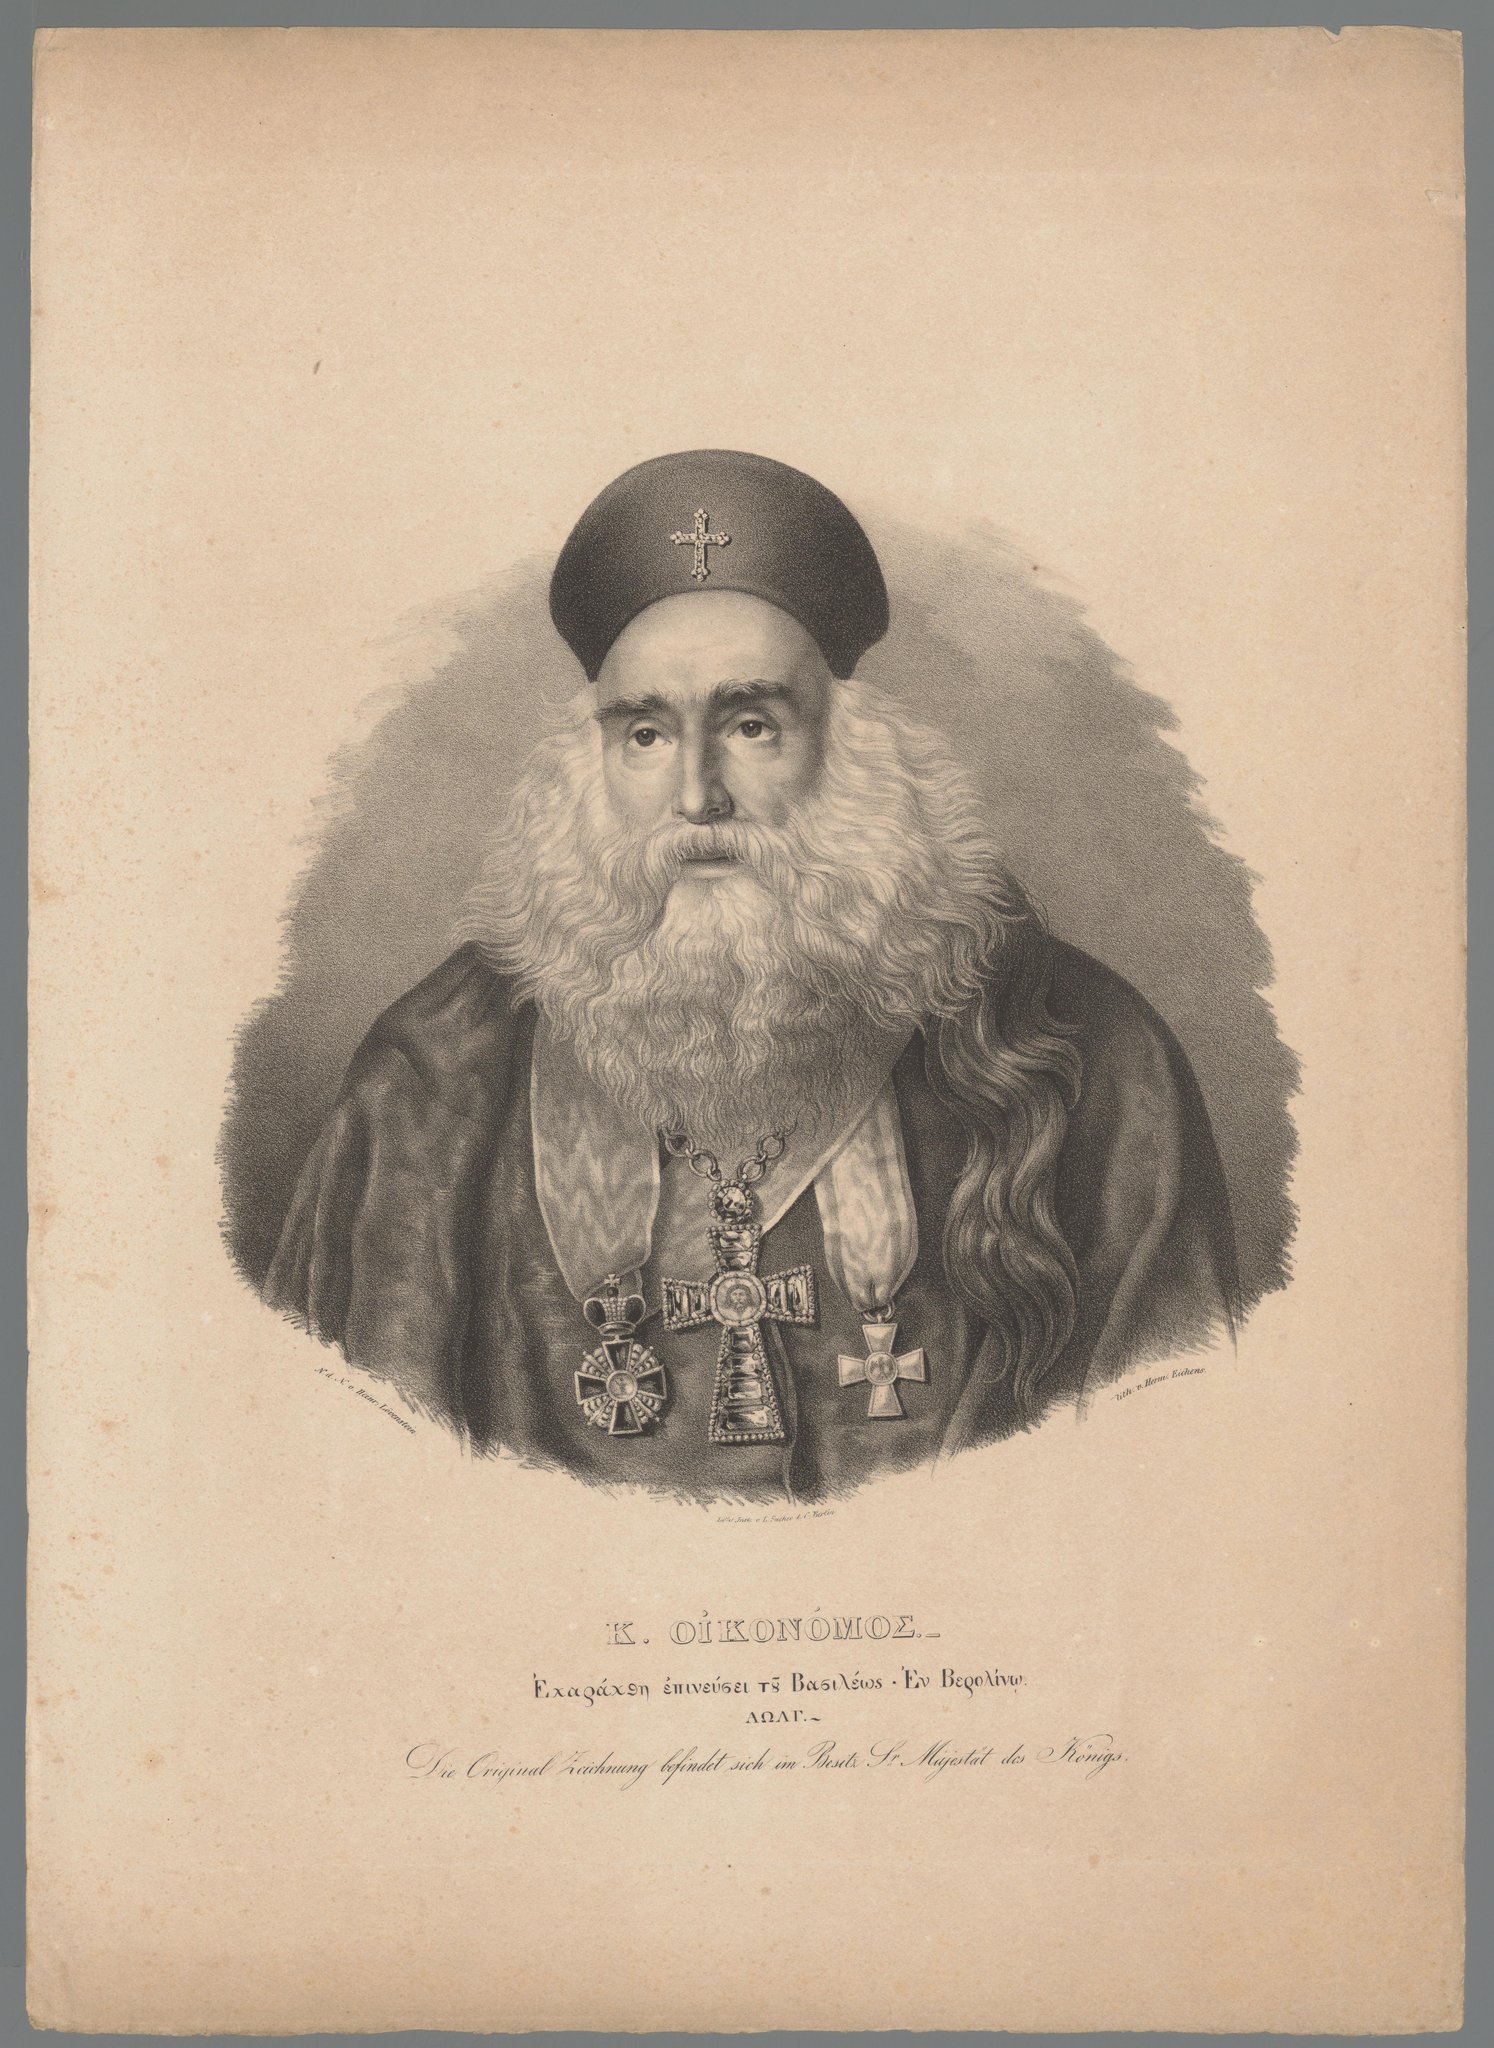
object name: print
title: Portret van Konstantinos Oikonomos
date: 1823-1886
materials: paper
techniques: lithograph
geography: berlin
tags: clergyman, historical persons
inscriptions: collector's mark: Lugt 2228